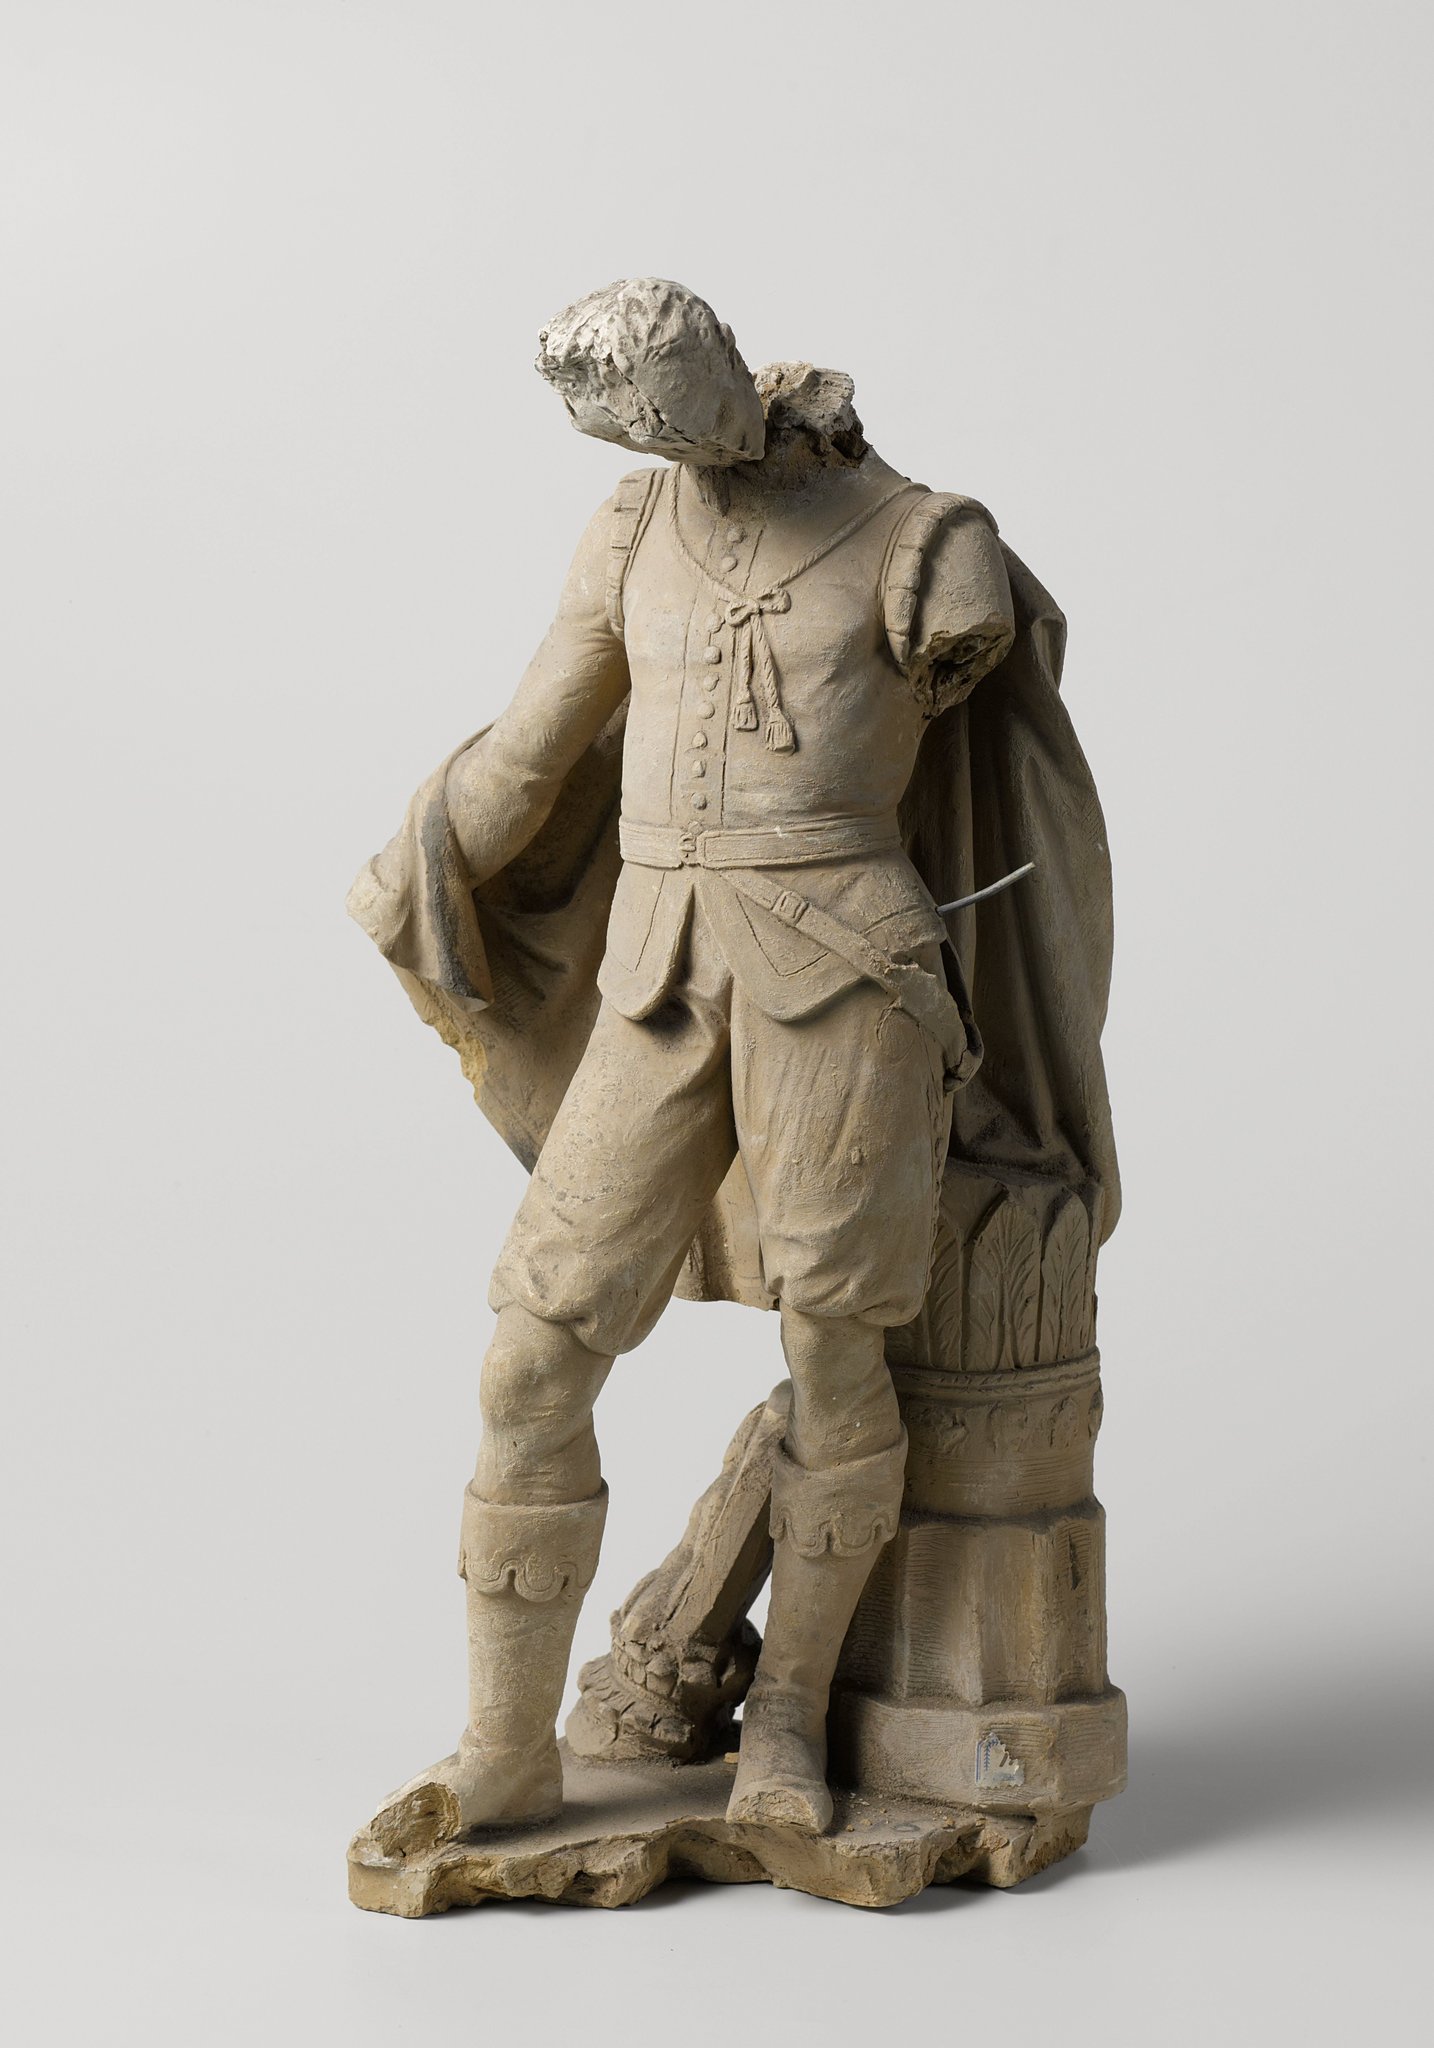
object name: sculpture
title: Ontwerp voor een monument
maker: eugène lacomblé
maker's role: draughtsman, painter, sculptor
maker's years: 1828-1905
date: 1870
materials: clay